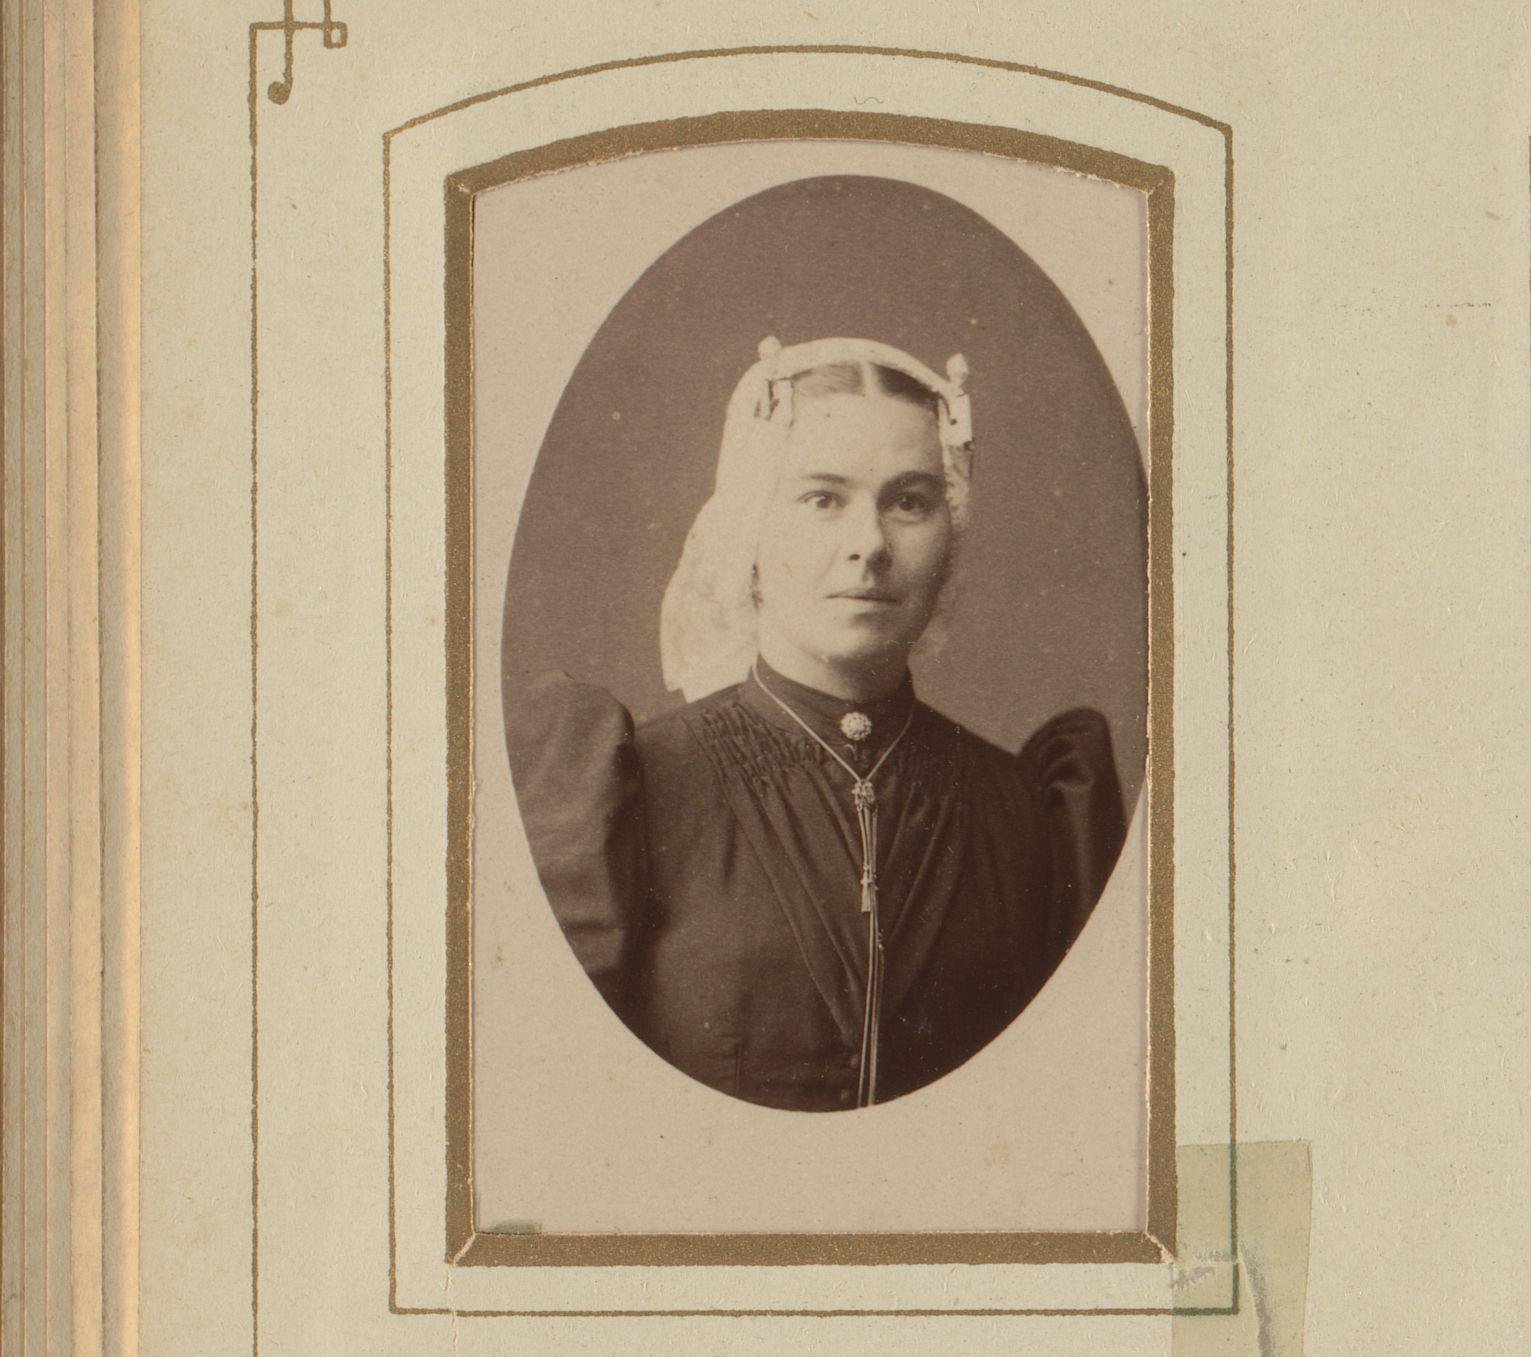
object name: semi enamel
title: Portret van een jonge vrouw met witte klederdrachtmuts en halsketting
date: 1885-1906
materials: cardboard, celluloid, photographic support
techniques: albumen print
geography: amsterdam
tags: historical persons - bb - woman, head-gear: cap, folk costume, regional costume, necklace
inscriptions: inscription: ‘W. G. Kuijer & Zonen/ Hofphotographen/ Amsterdam/ Westermarkt 19./ Speciale Inrichting/ voor/ VERGROOTINGEN/ in alle Formaten’